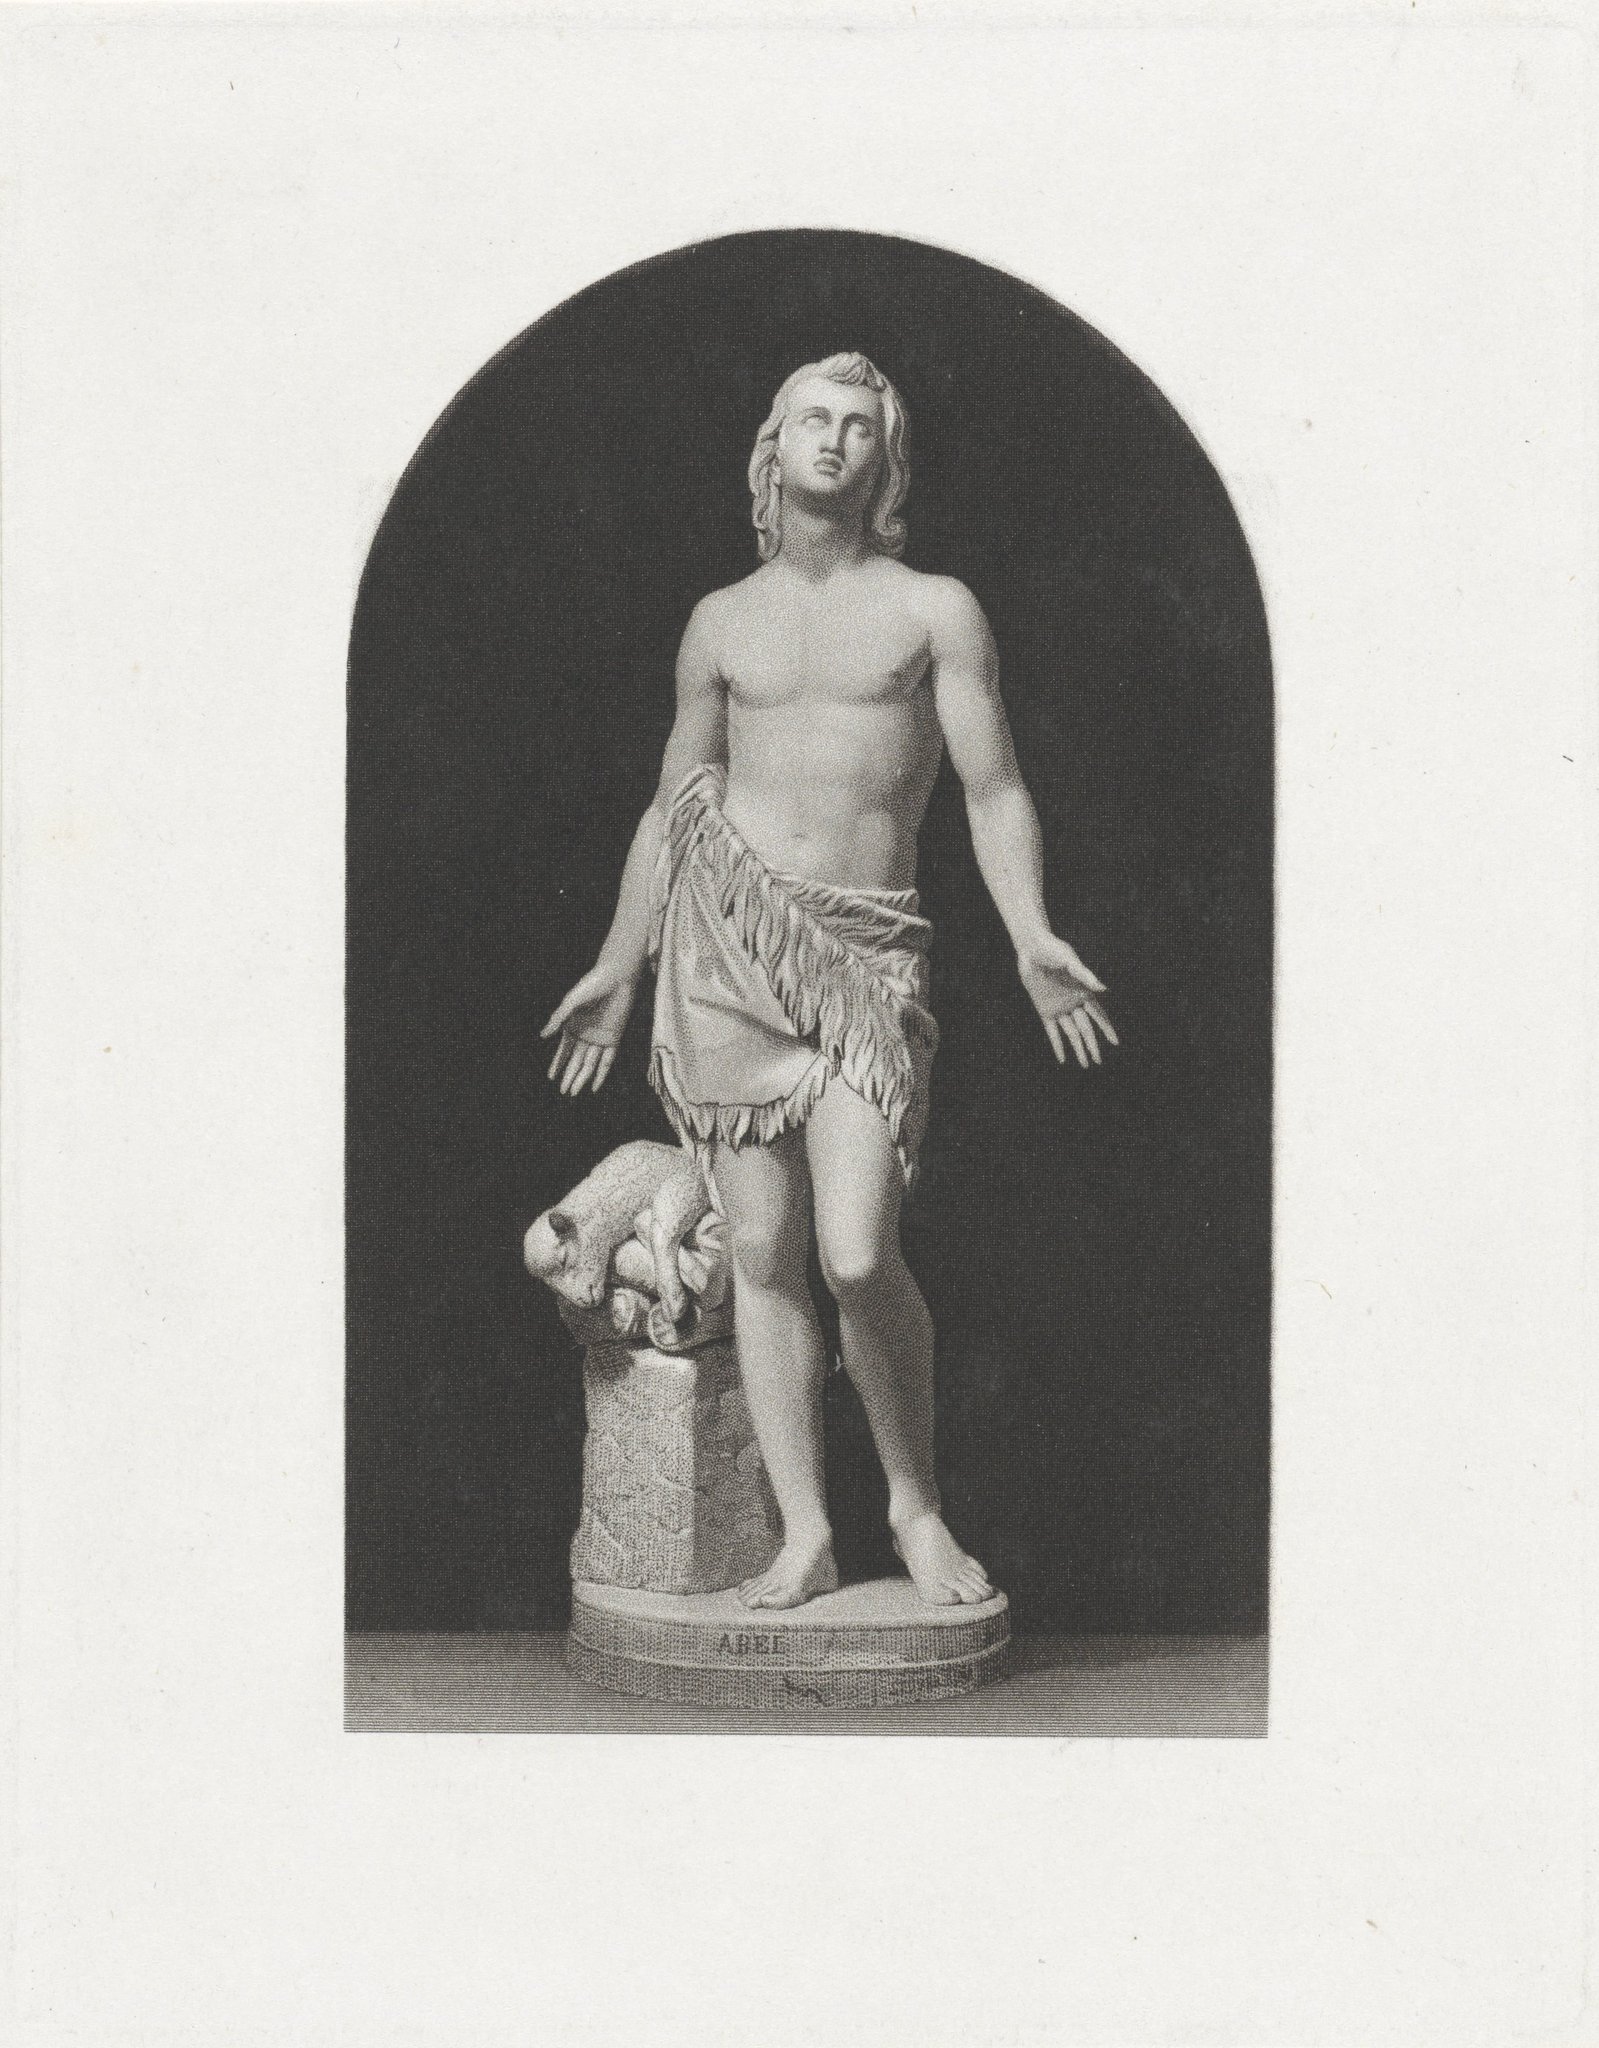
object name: print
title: Abel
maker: dirk jurriaan sluyter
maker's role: draughtsman, print maker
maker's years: 1811-1886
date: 1826-1886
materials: paper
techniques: aquatint, engraving, etching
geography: amsterdam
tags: monument, statue, abel (not in biblical context); possible attributes: sheep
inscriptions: collector's mark: Lugt 2228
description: Standbeeld van Abel. Op een brandaltaar naast hem ligt het lam.